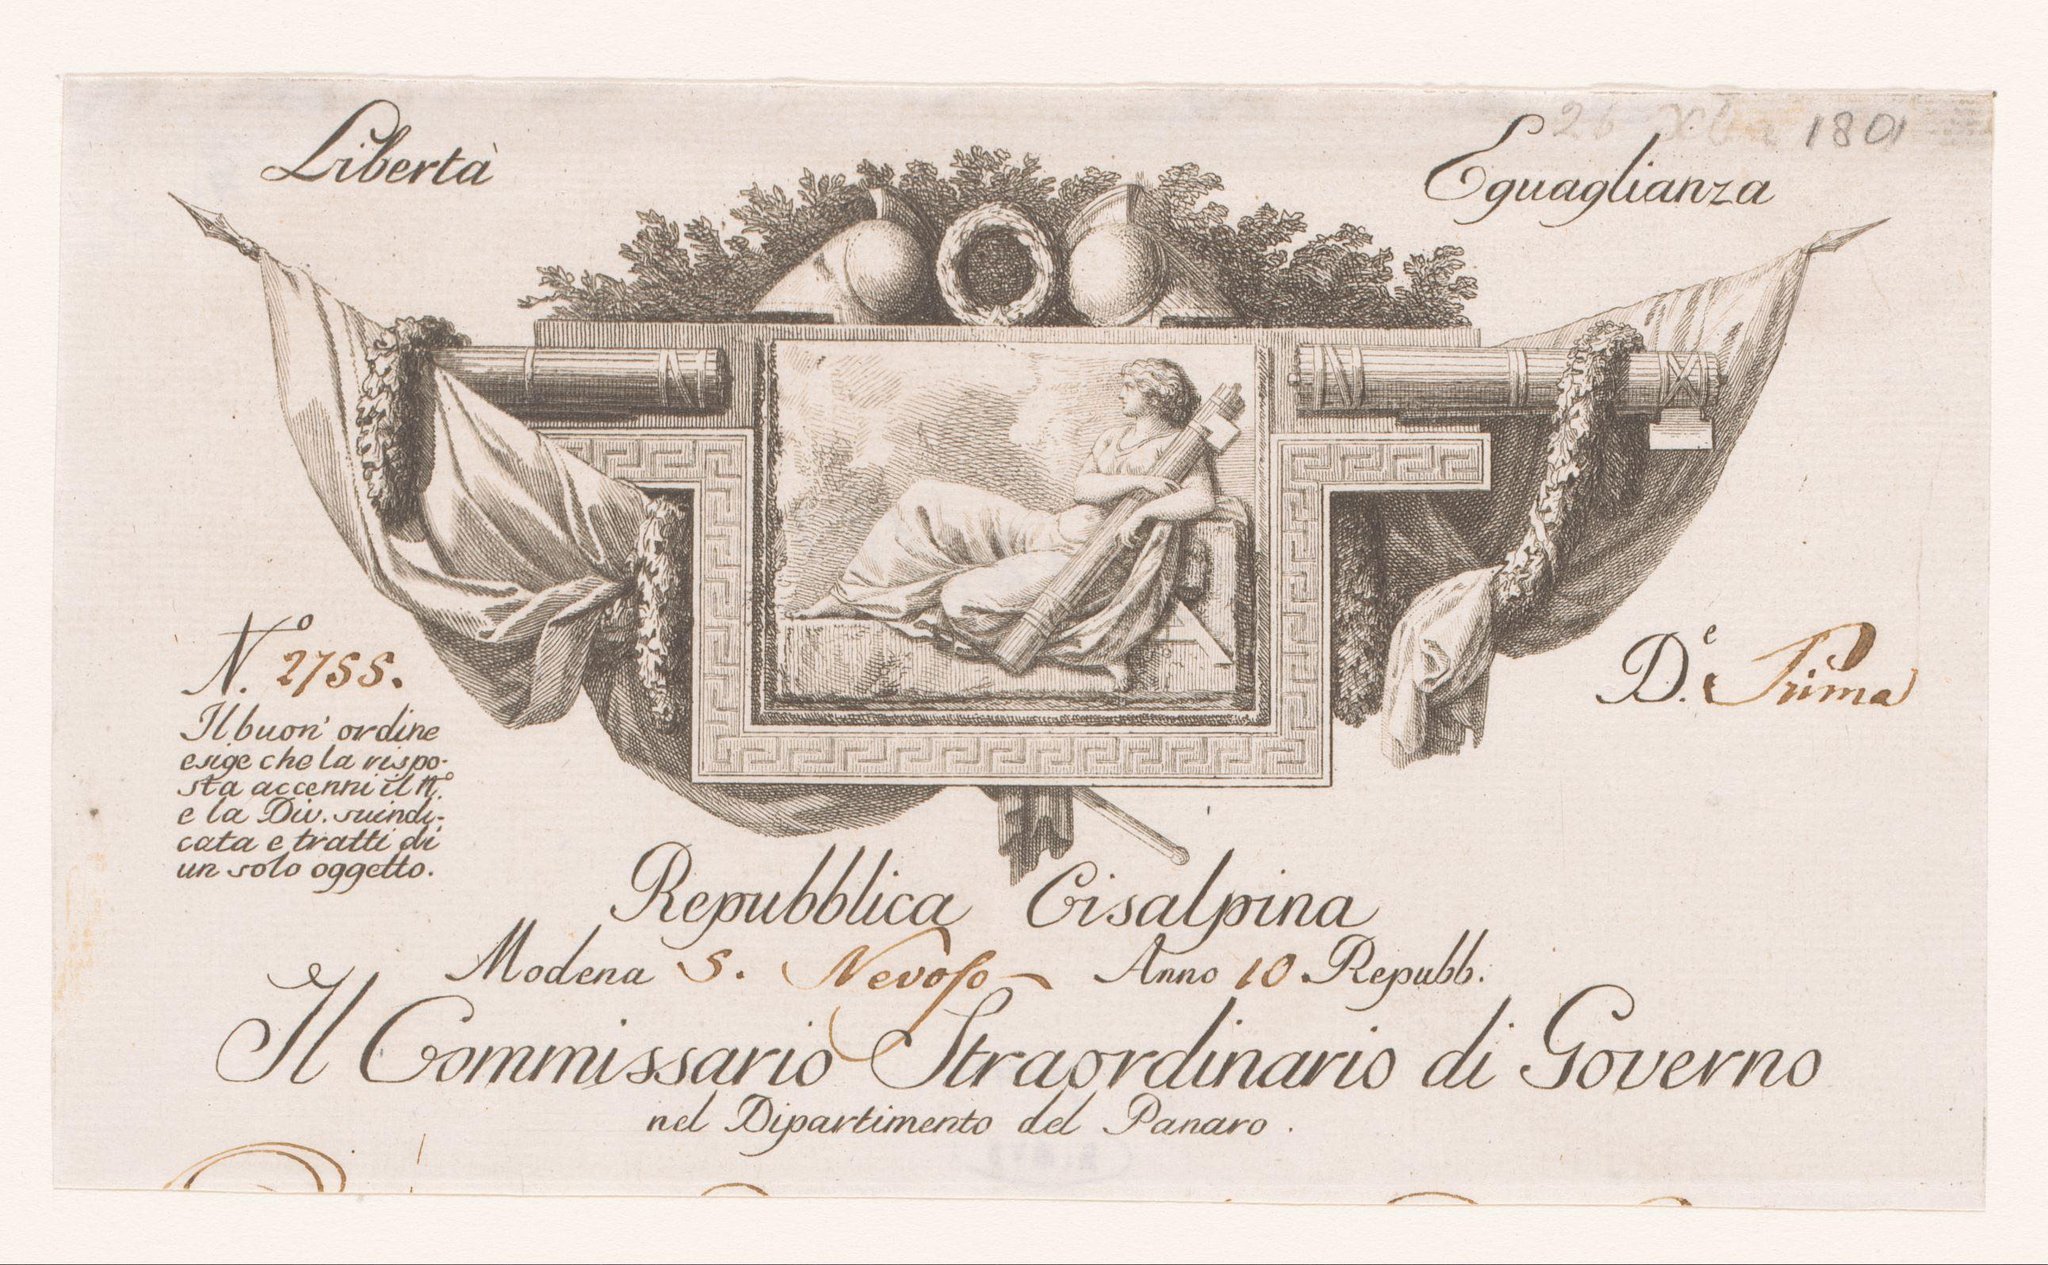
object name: print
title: Briefhoofd voor de Cisalpijnse Republiek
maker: Anonymous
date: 1797-1801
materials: paper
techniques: etching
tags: governmental and representative bodies, letter, envelope, freedom, liberty; 'libertà' (ripa)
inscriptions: collector's mark: Lugt 2228